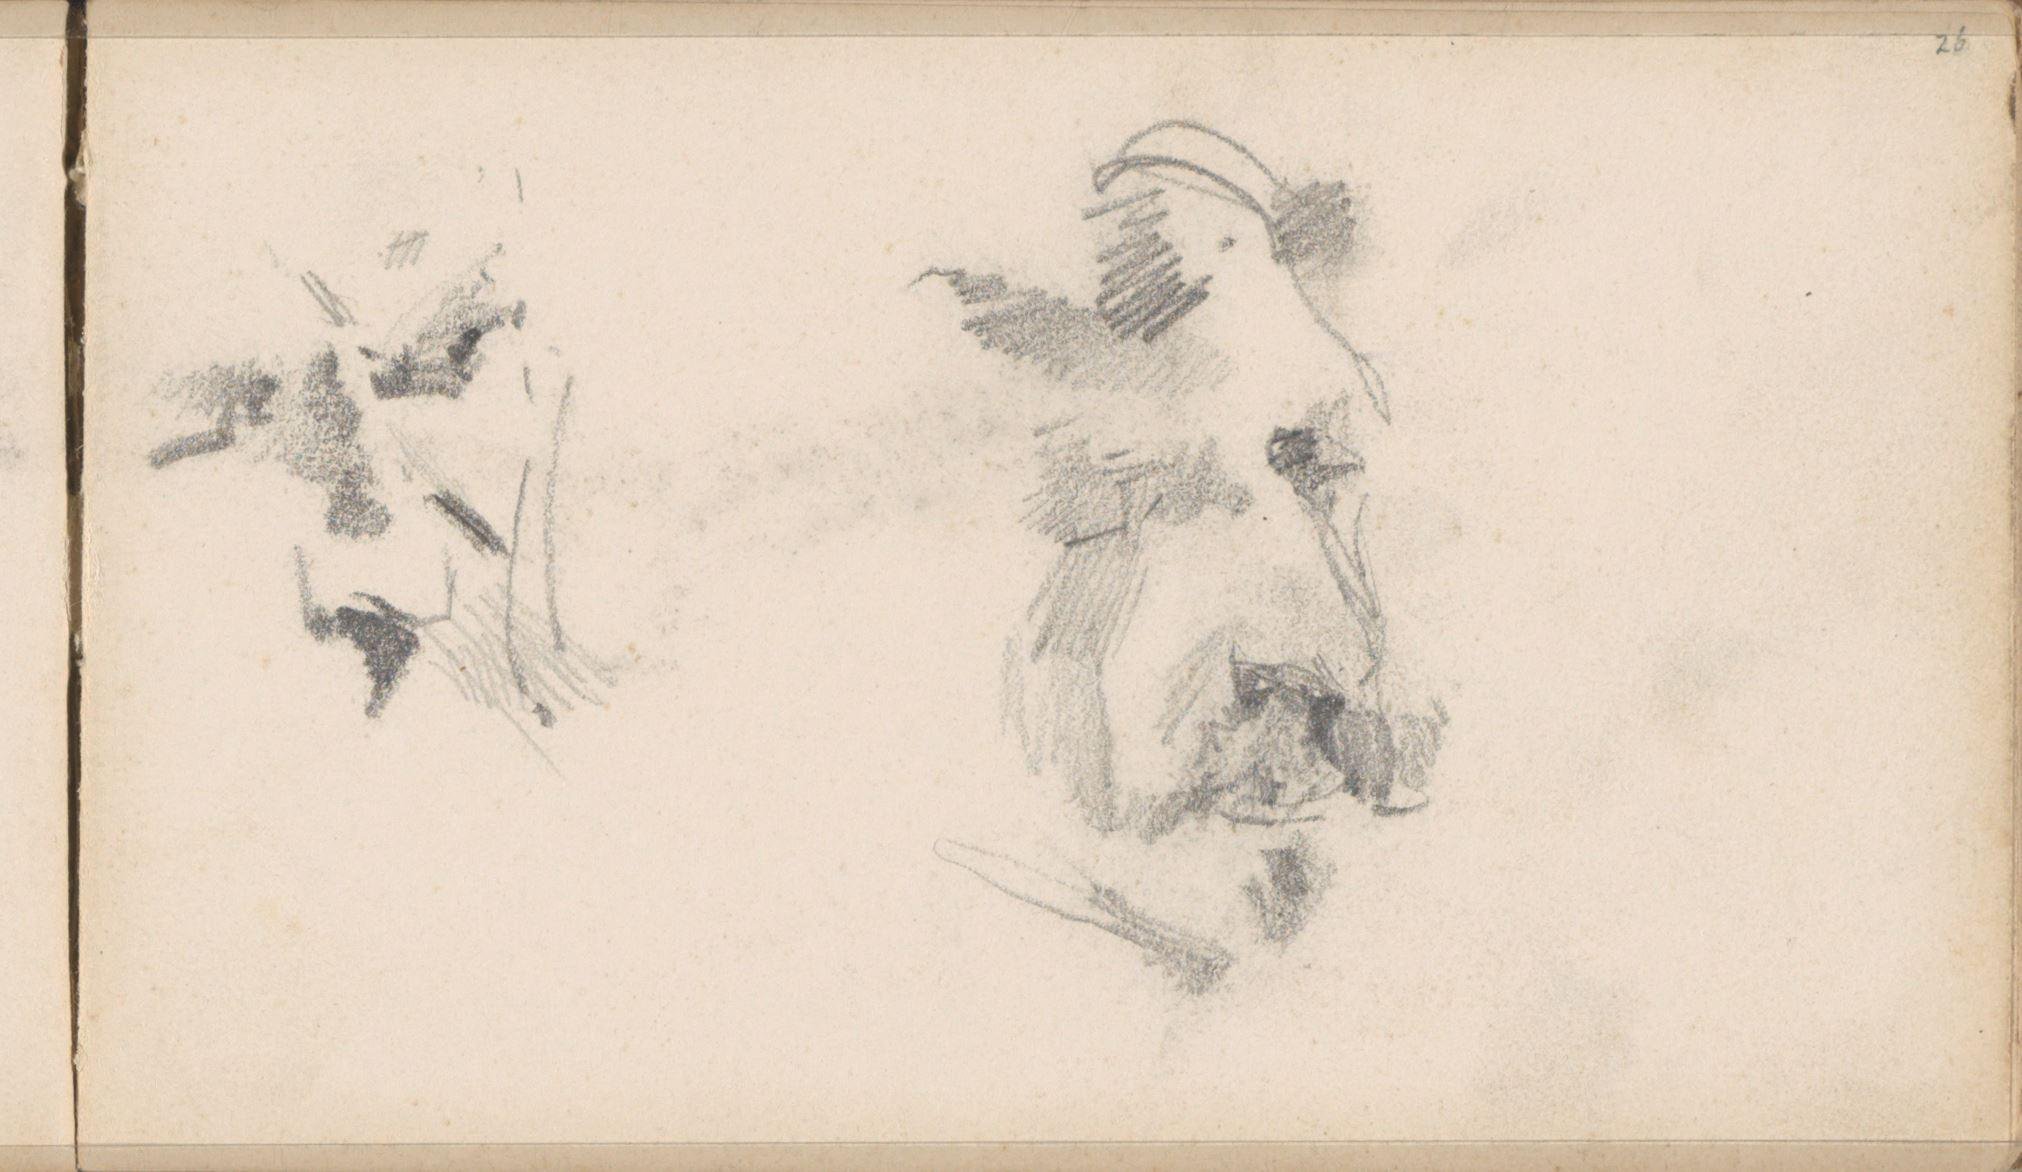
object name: sketchbook leaf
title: Twee mannengezichten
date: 1881-1883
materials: paper, pencil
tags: face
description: Pagina 26 uit een schetsboek met 30 bladen.